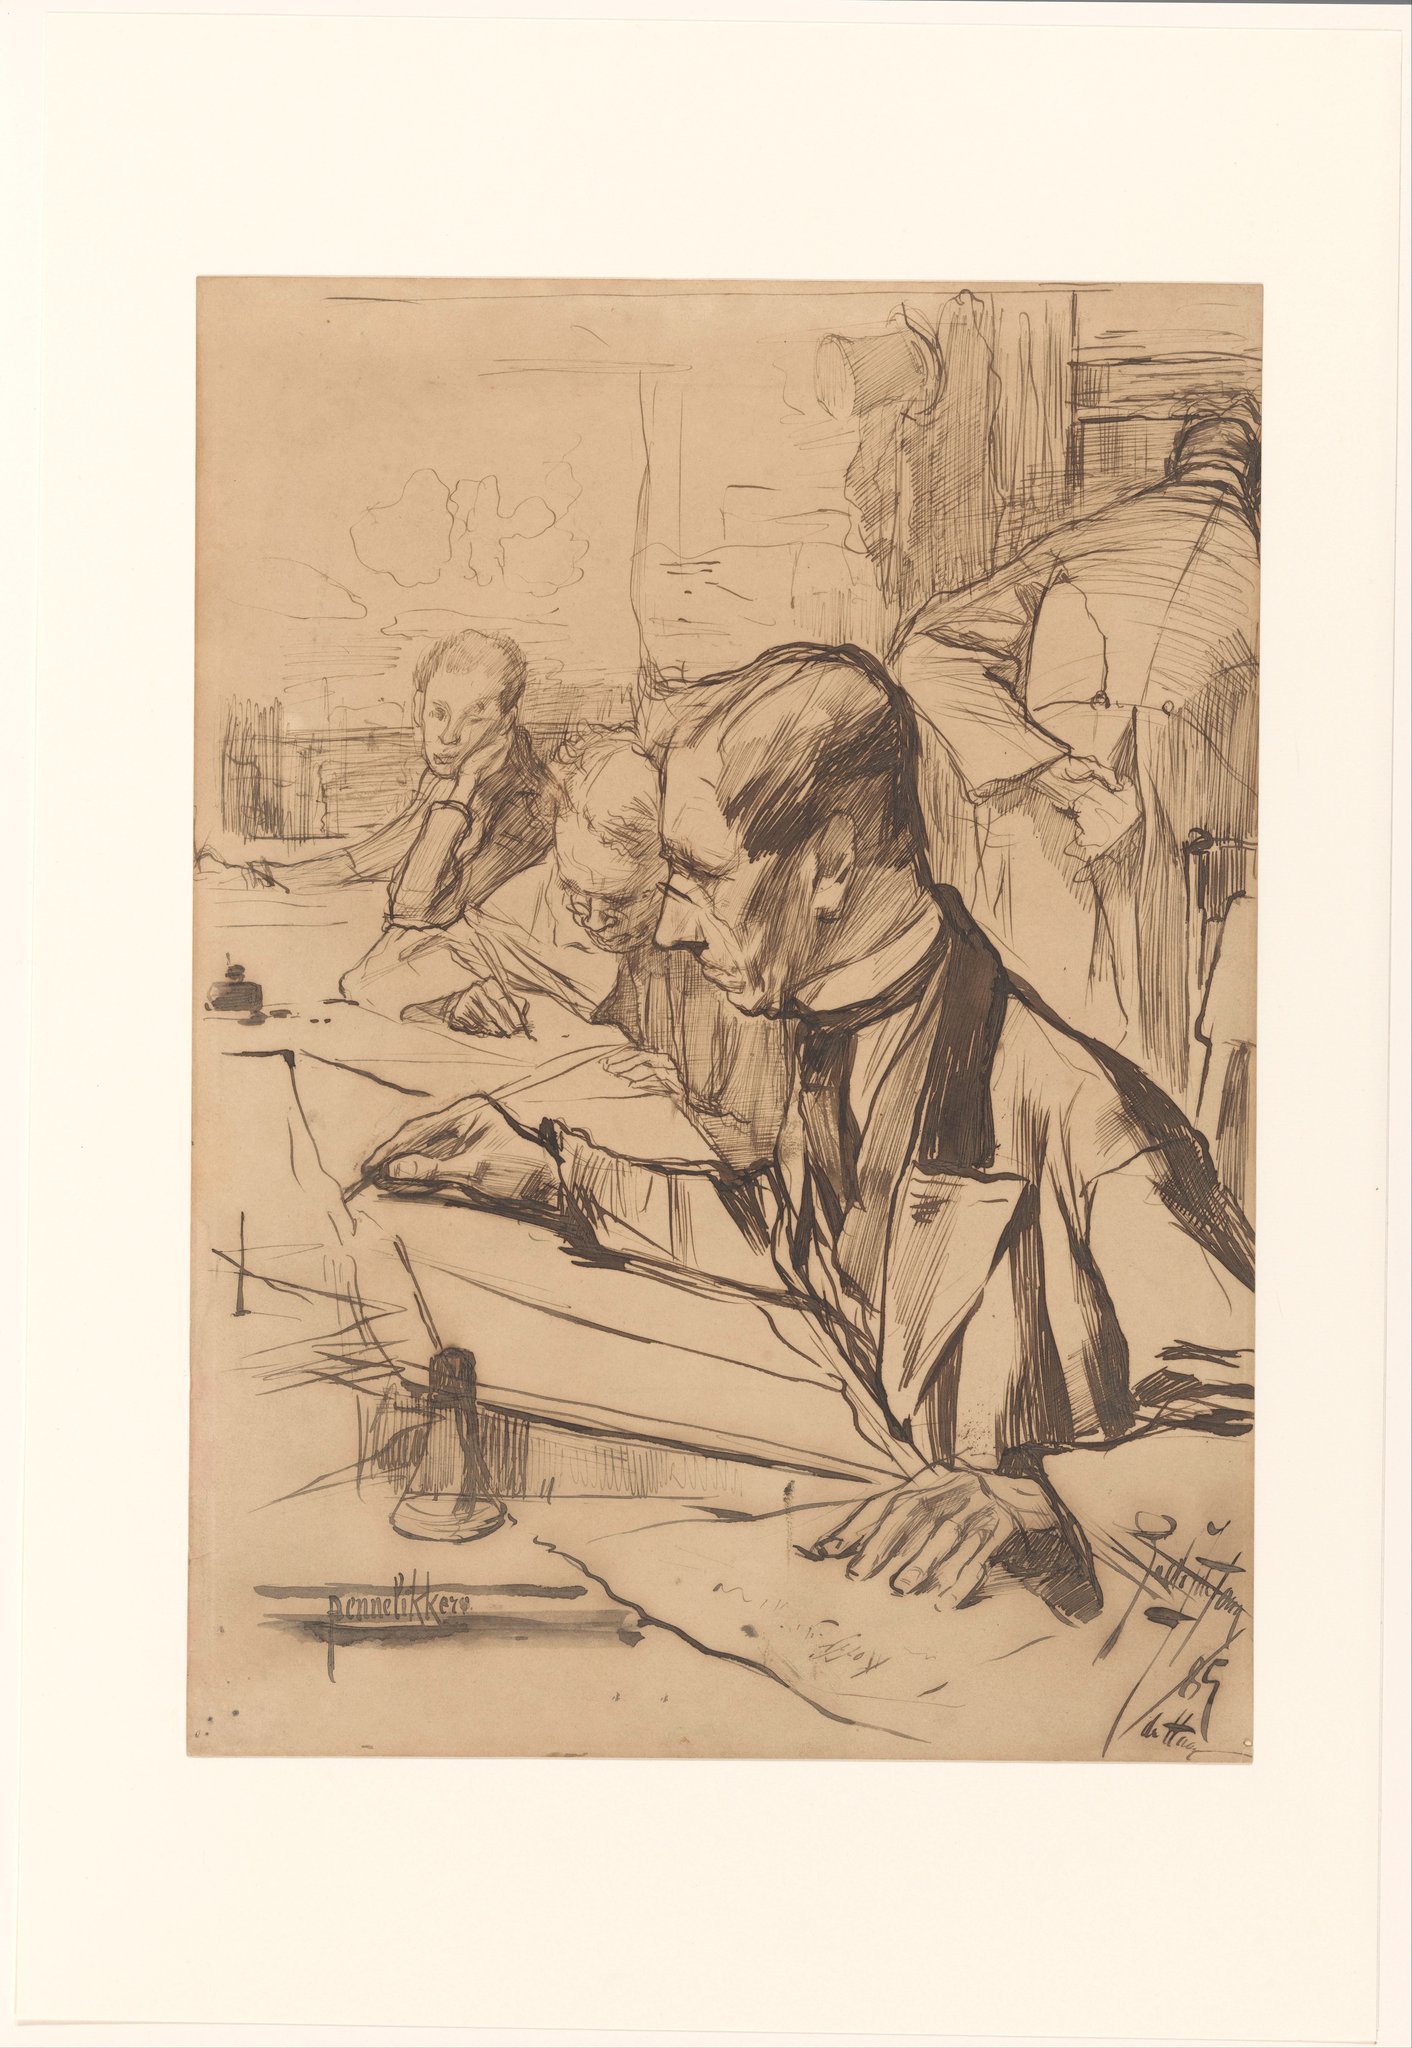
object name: drawing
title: De pennelikkers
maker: pieter de josselin de jong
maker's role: draughtsman, painter, print maker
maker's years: 1861-1906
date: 1885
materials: ink, paper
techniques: pen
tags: handwriting, writing as activity, official; civil servant; functionary (in general)